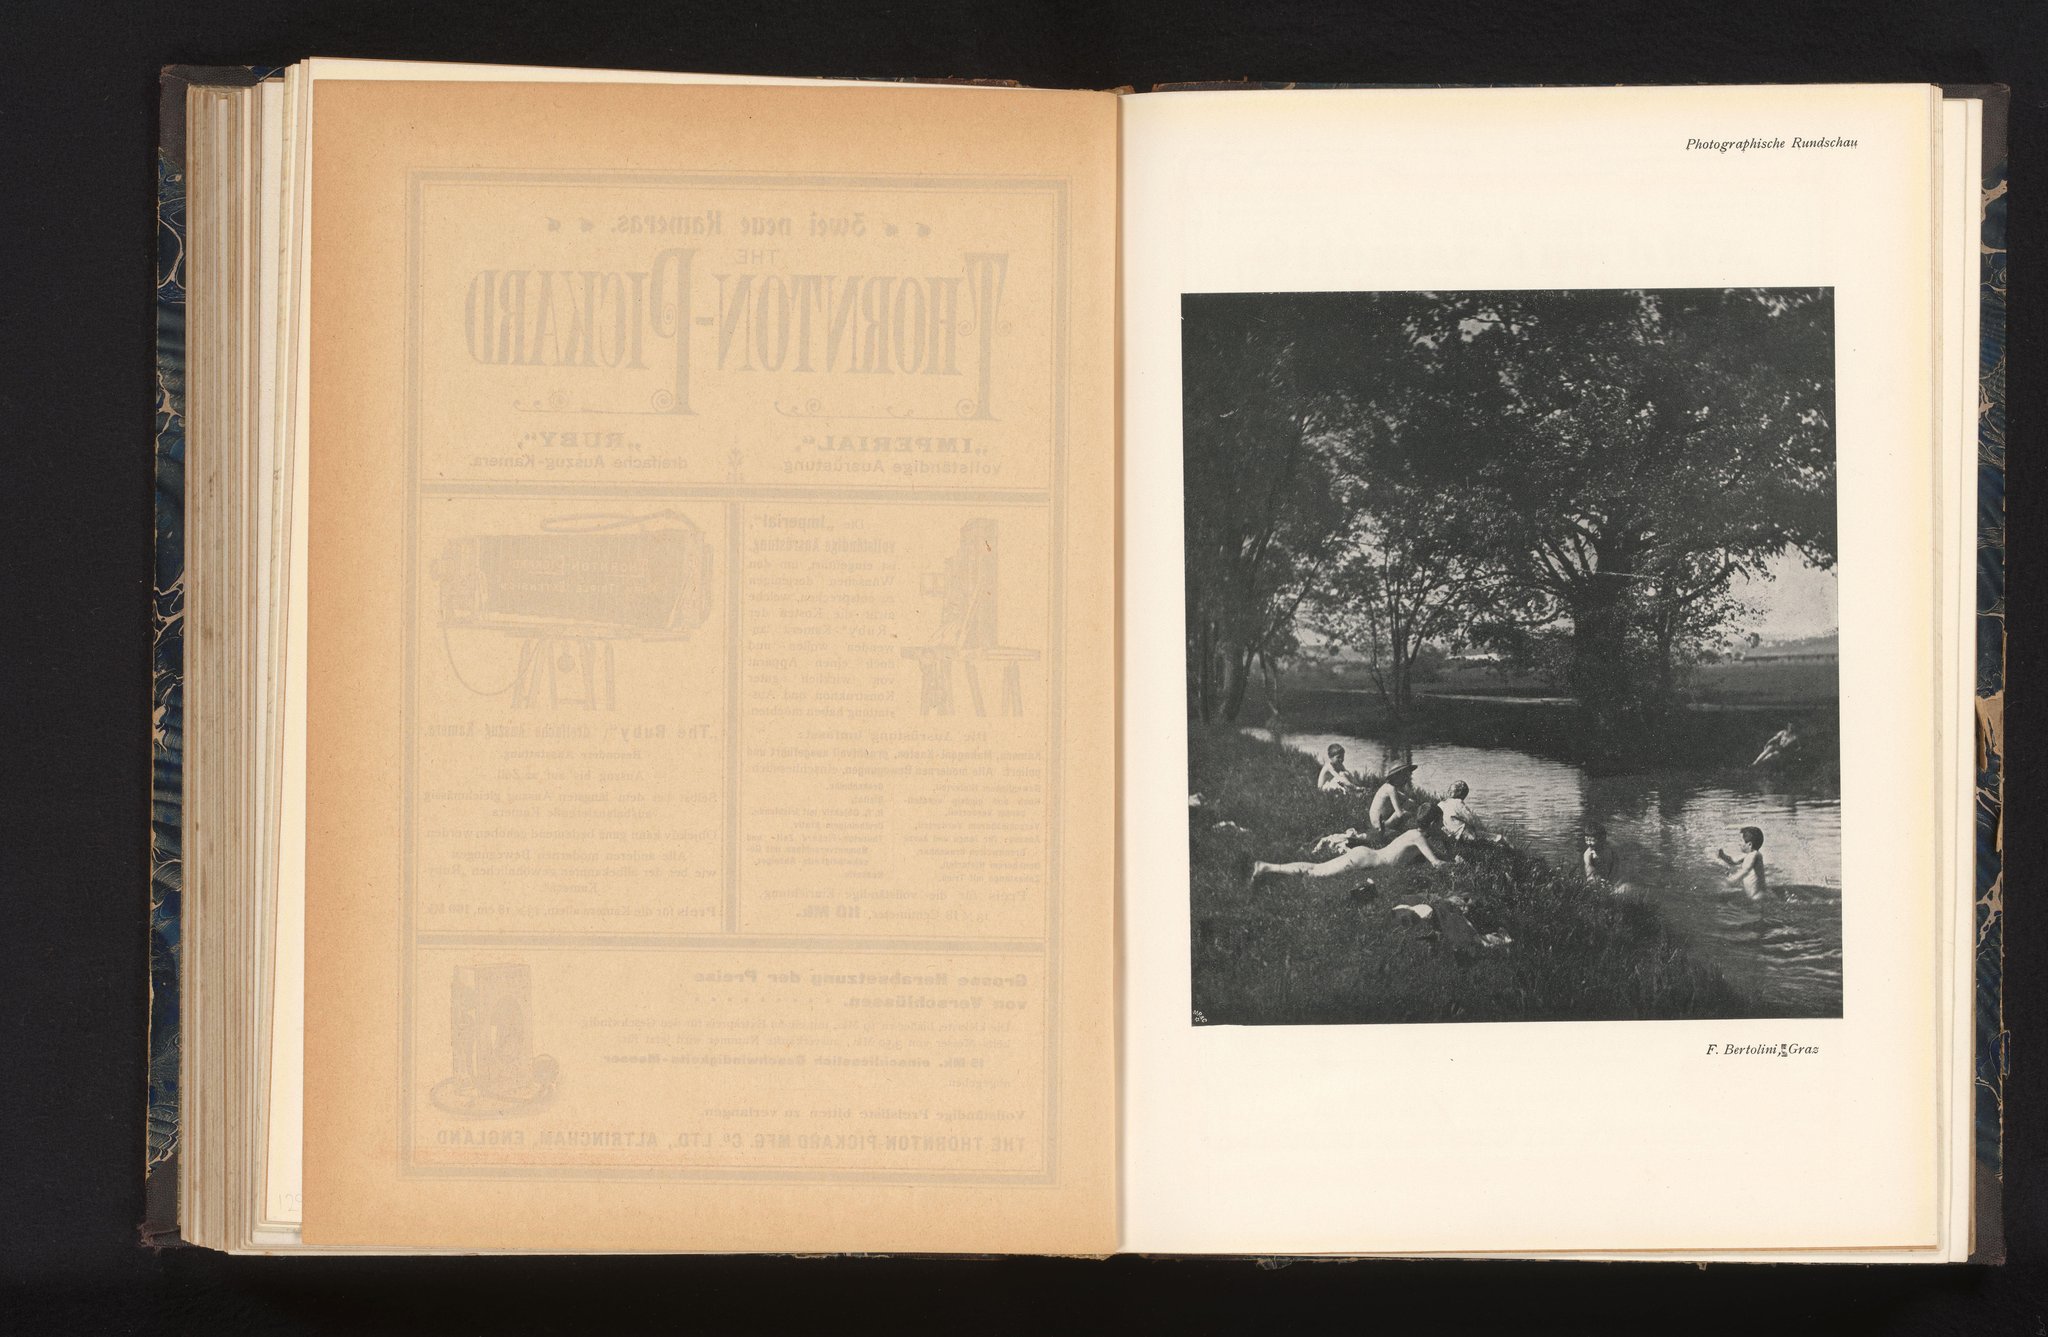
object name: photomechanical print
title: Gezicht op een aantal kinderen die bloot bij een sloot liggen en in de sloot spelen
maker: franz bertolini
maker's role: fotograaf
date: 1897-1902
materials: paper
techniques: autotype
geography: berlin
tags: child, small canal, ditch